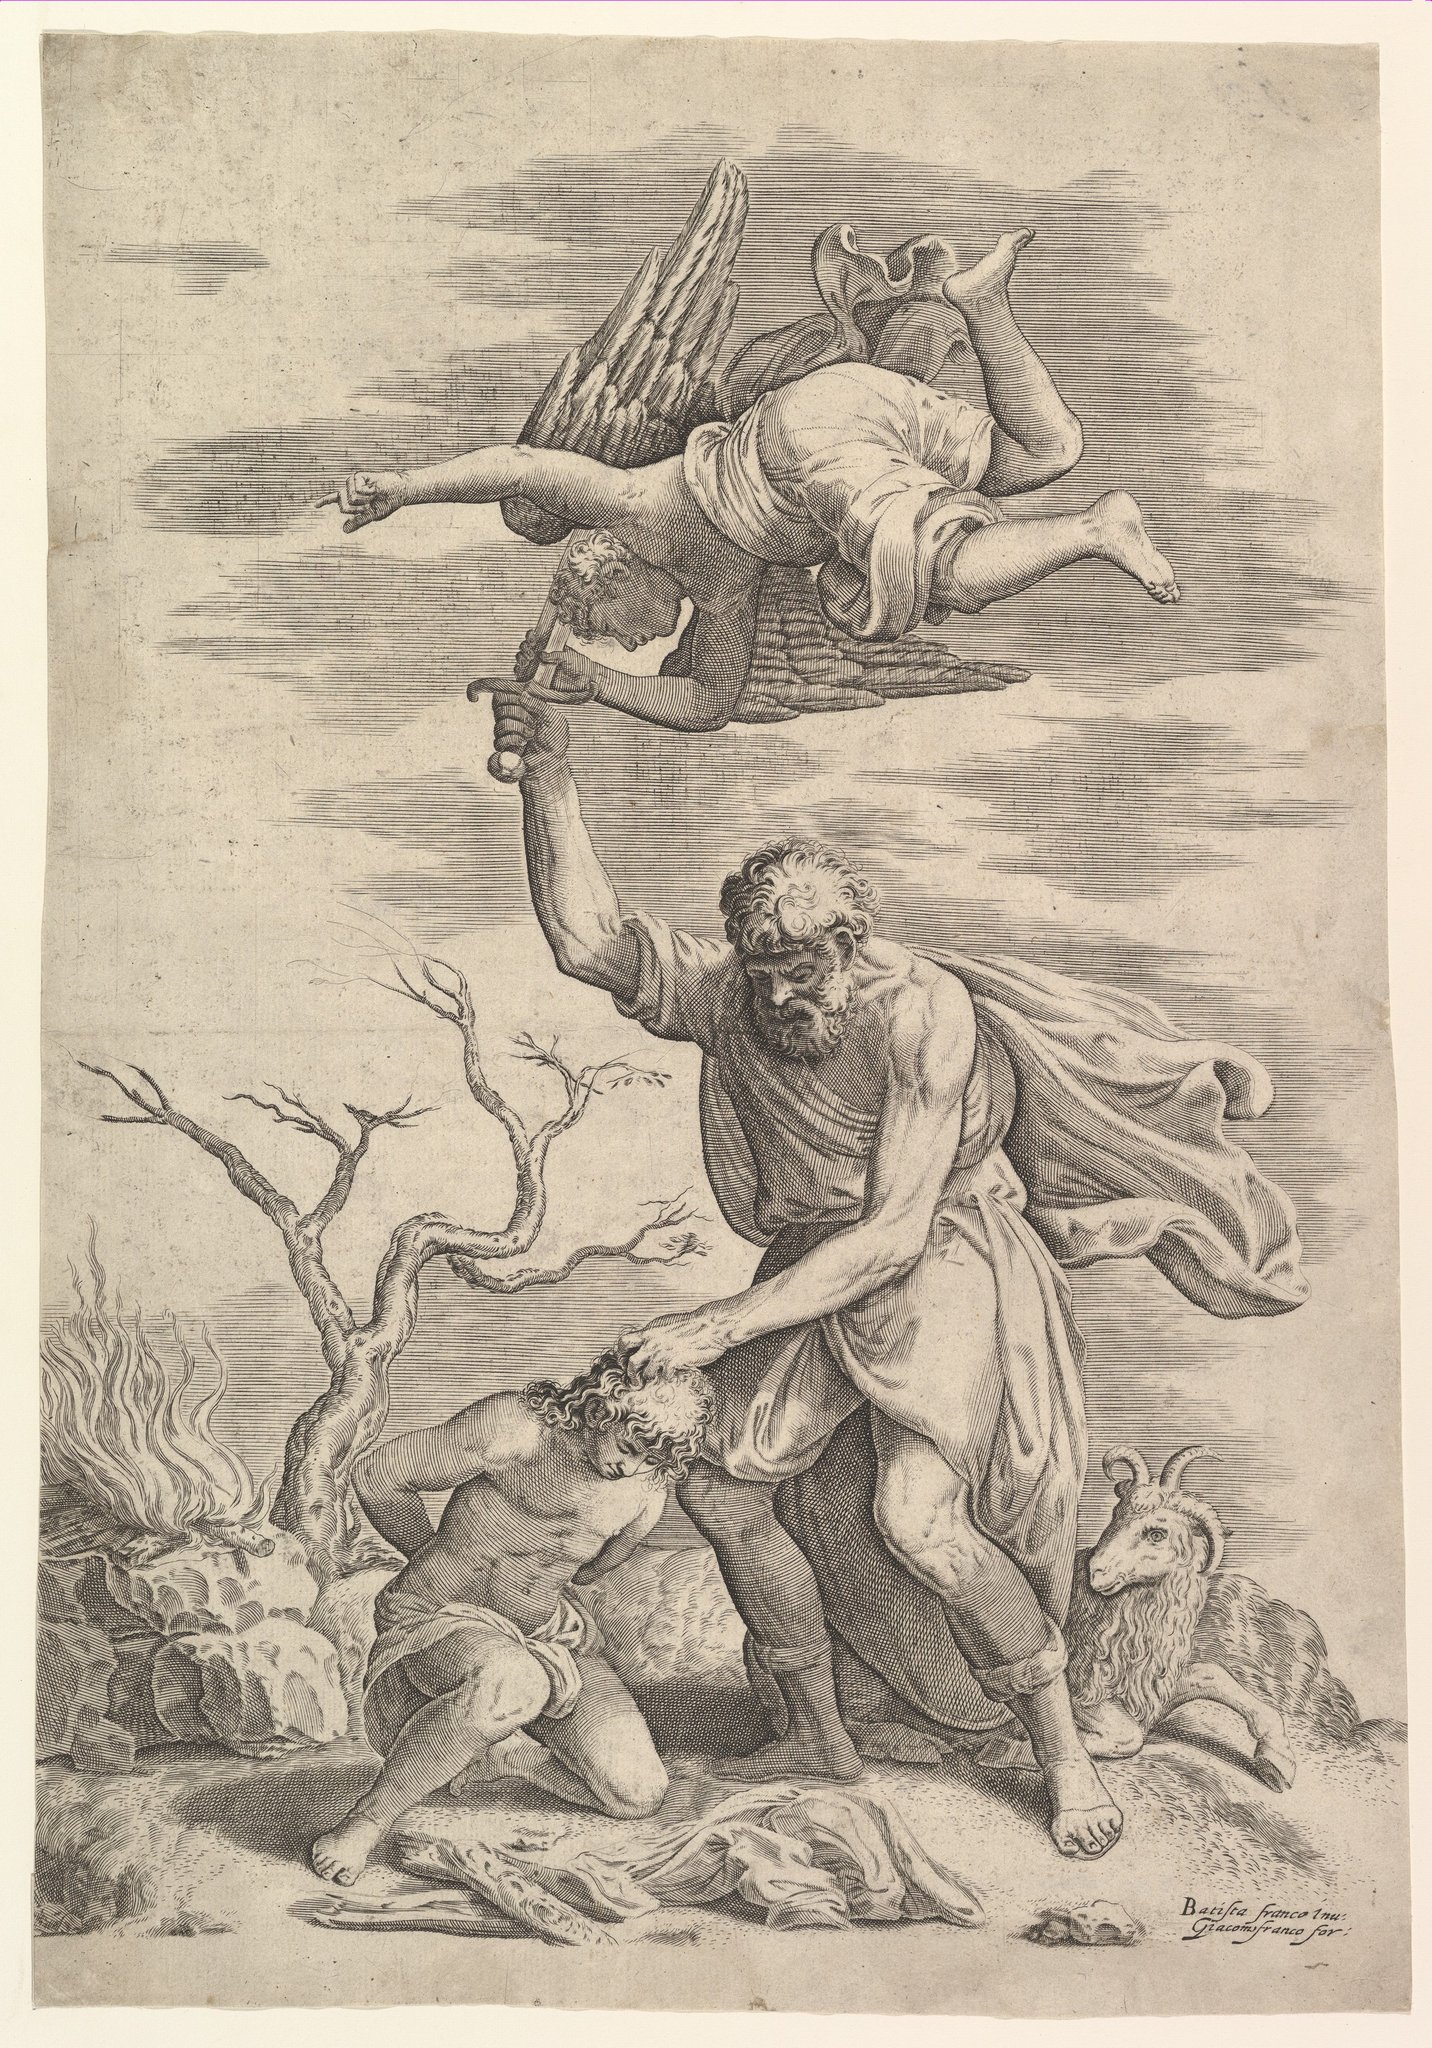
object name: print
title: The Angel Staying the Arm of Abraham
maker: battista franco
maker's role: artist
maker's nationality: italian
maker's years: 1510-1561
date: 1510-1561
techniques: engraving, etching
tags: men,rams,trees,angels,abraham